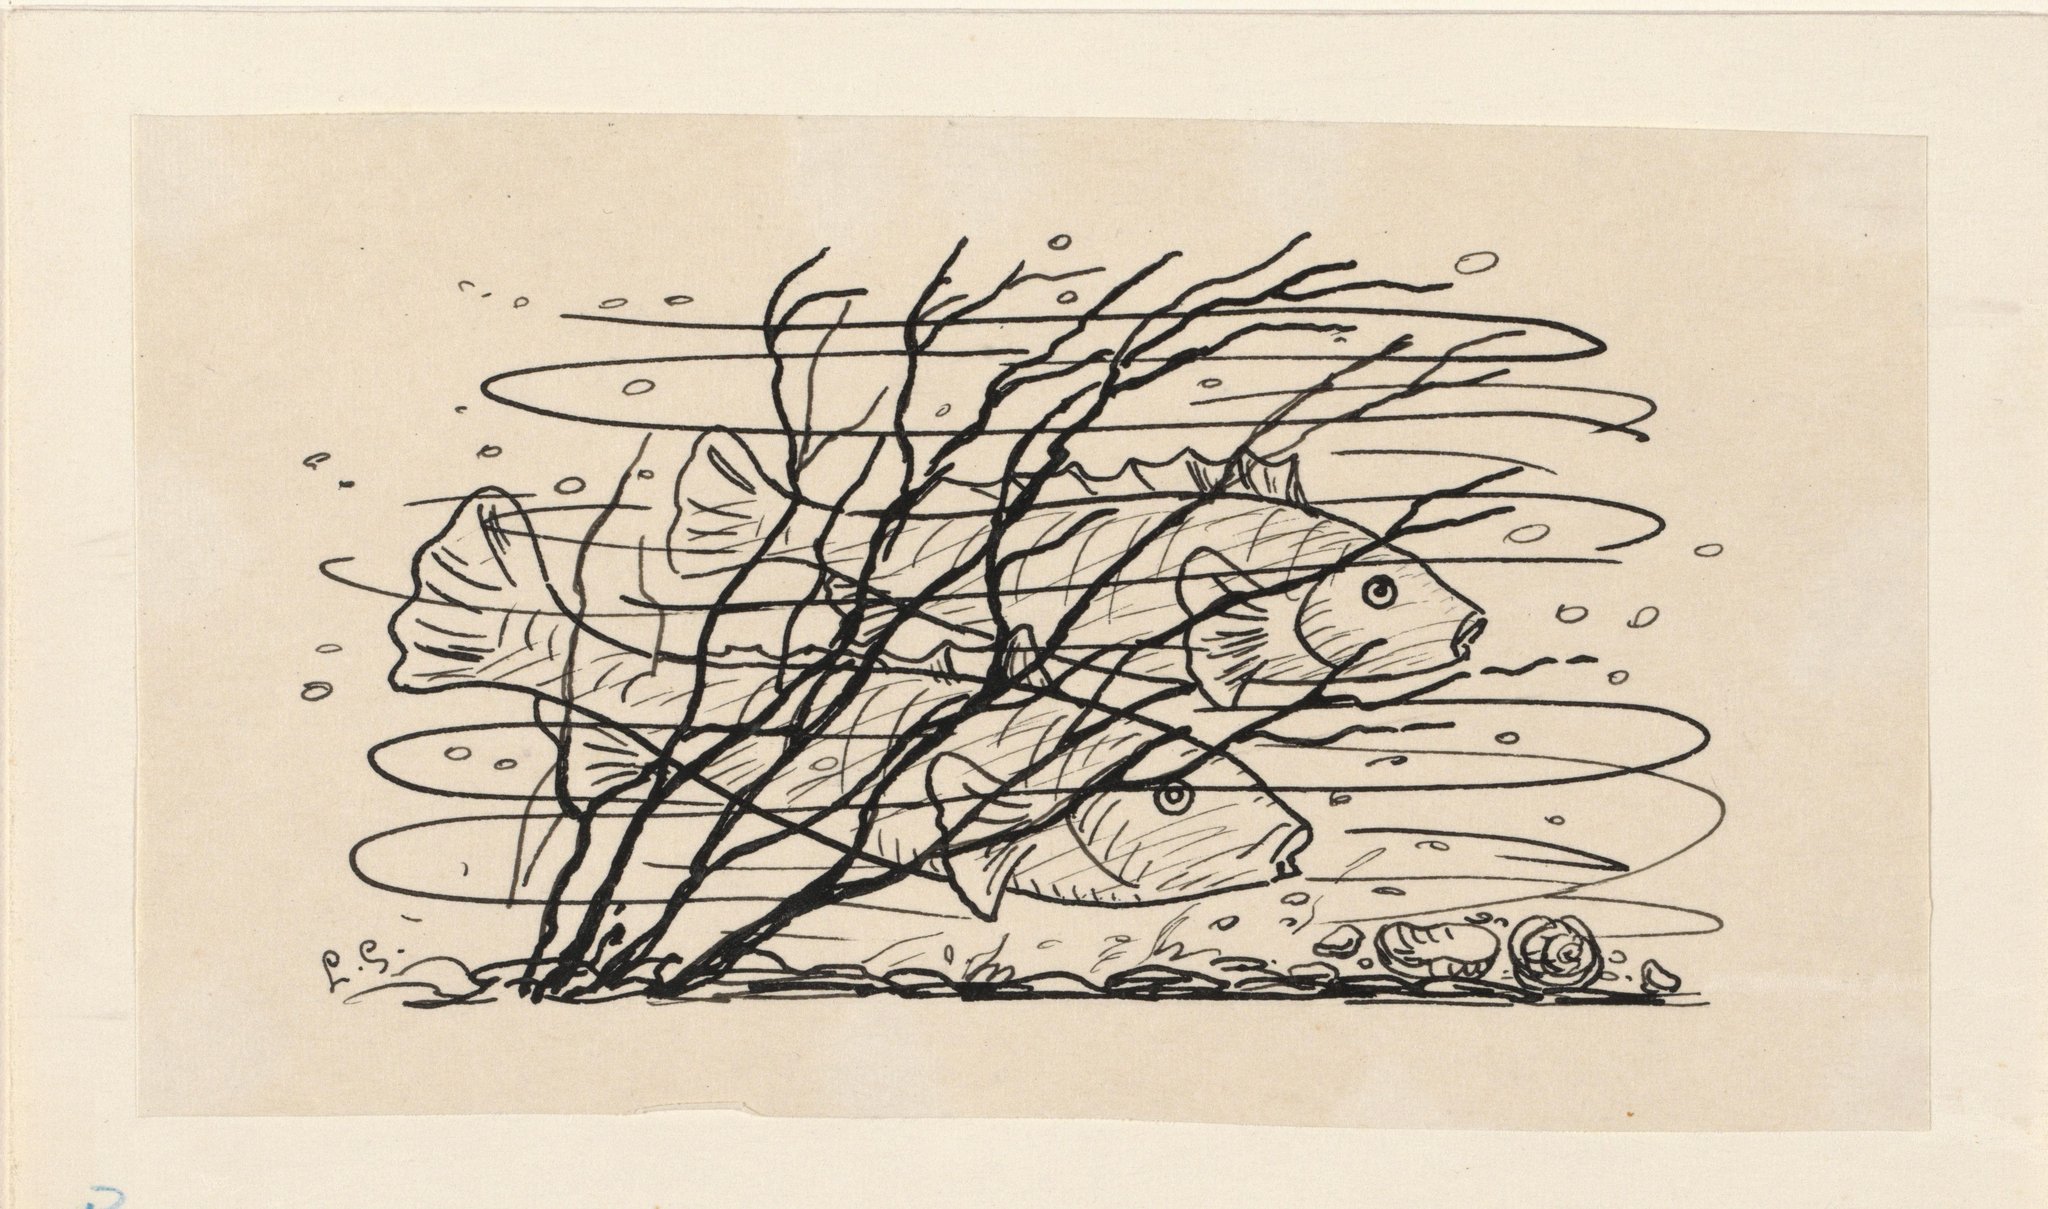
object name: drawing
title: Twee vissen in het water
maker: leo gestel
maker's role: draughtsman, print maker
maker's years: 1881-1941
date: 1939-1941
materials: ink, paper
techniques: pen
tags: fishes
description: Mogelijk een ontwerp voor een illustratie voor: De Gemeenschap 17, 1941.